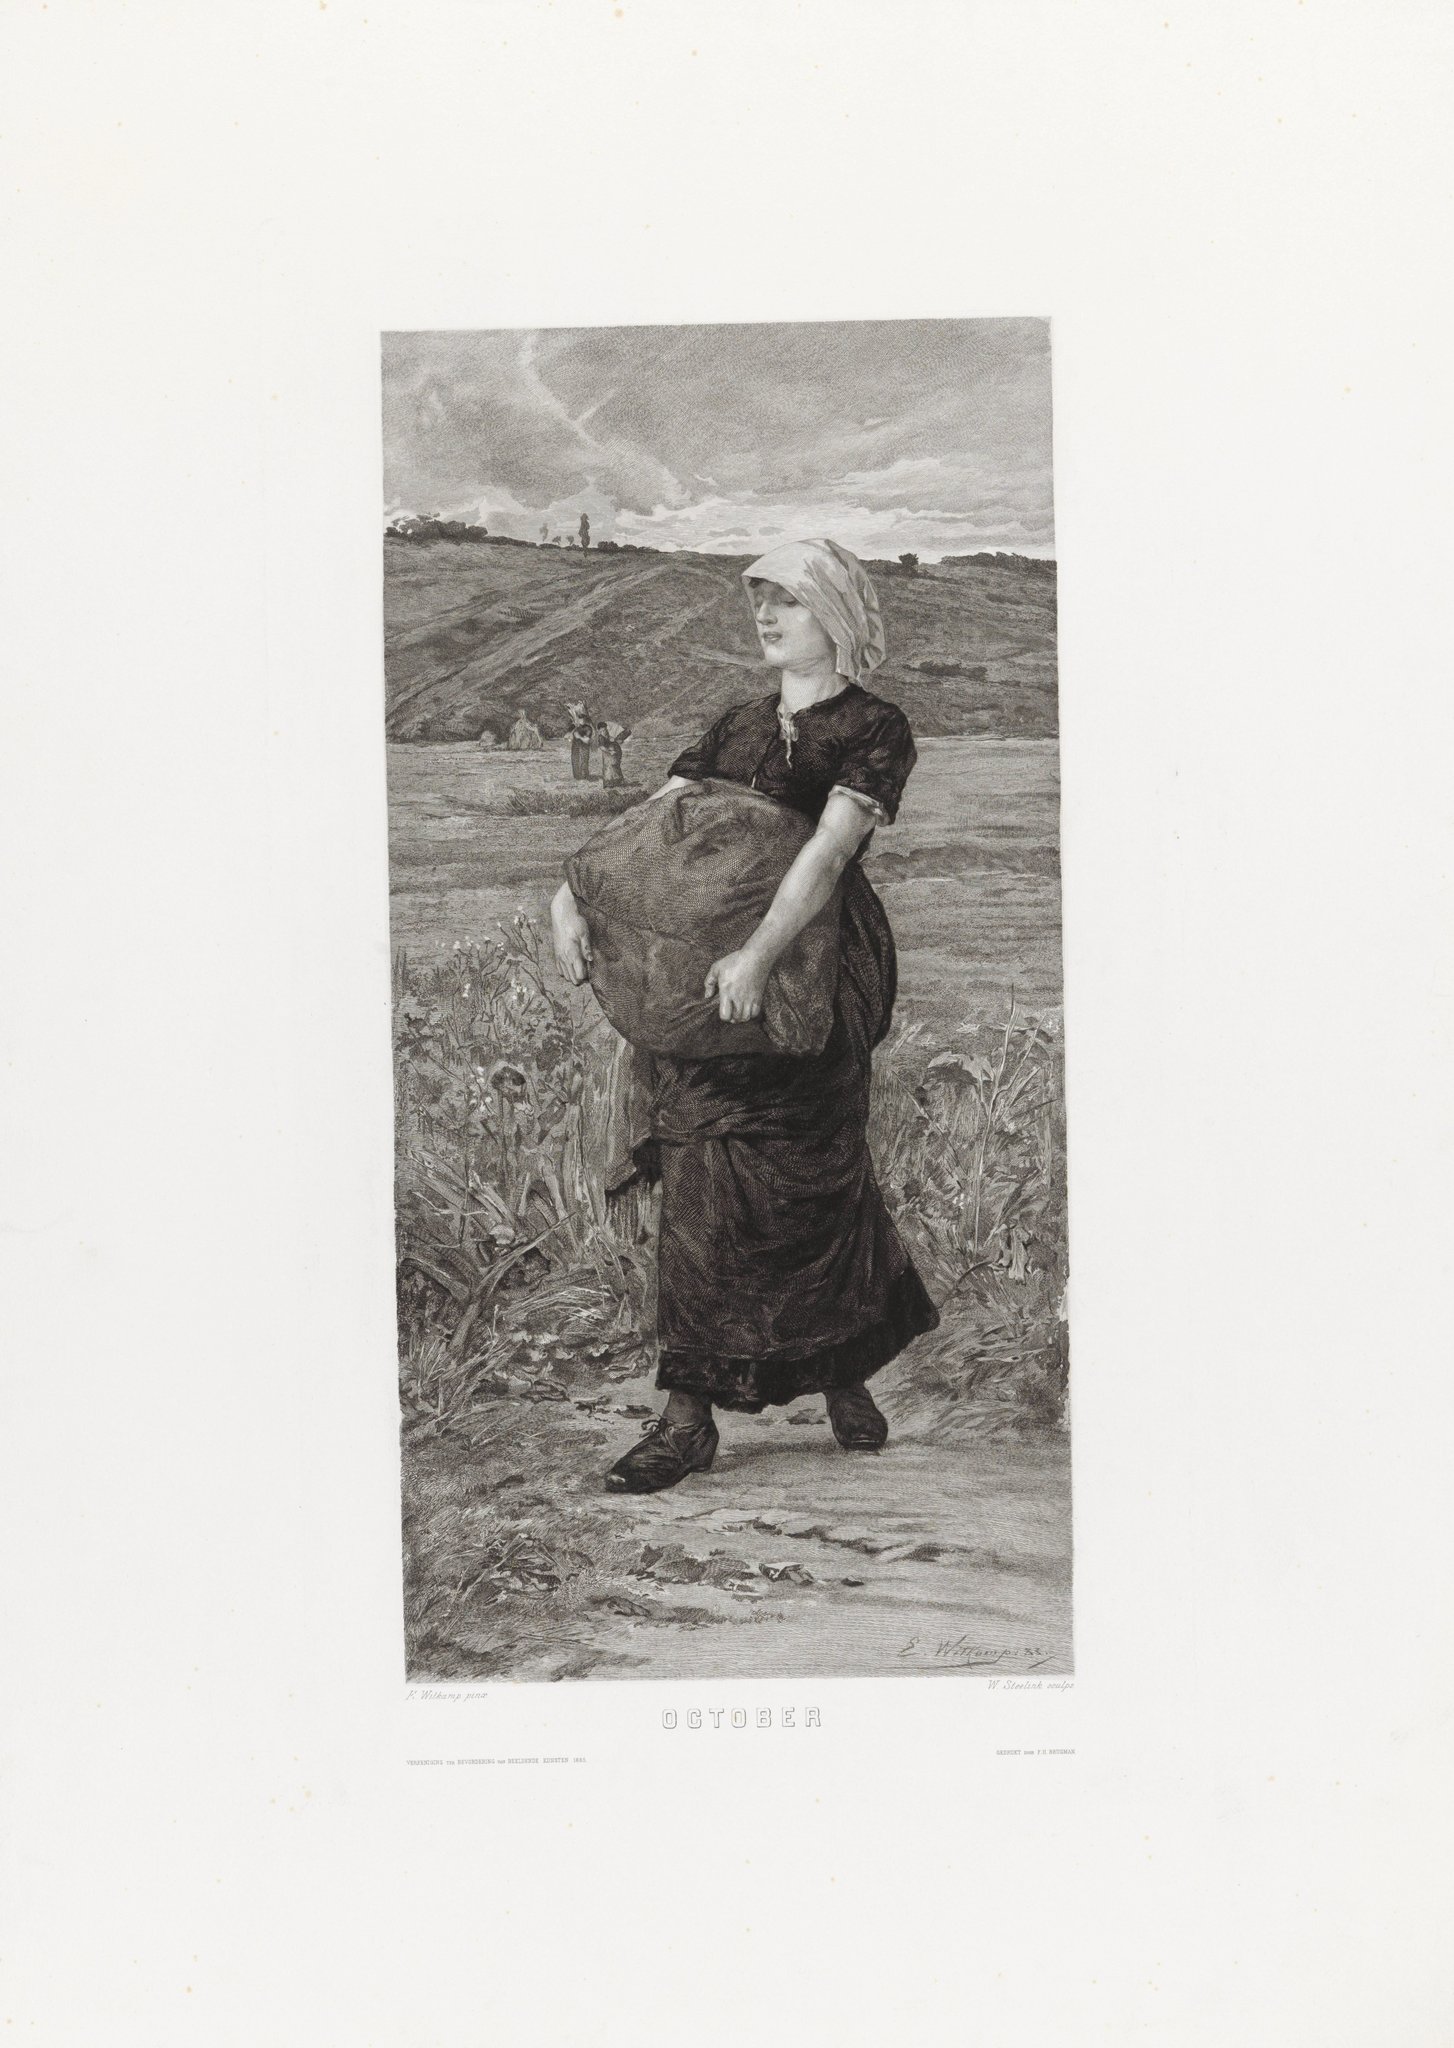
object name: print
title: Vrouw op het veld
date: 1885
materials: paper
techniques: engraving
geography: amsterdam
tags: carrying something, storing in sacks ~ harvest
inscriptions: collector's mark: Lugt 2228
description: Een vrouw draagt een grote gevulde zak op een veld.